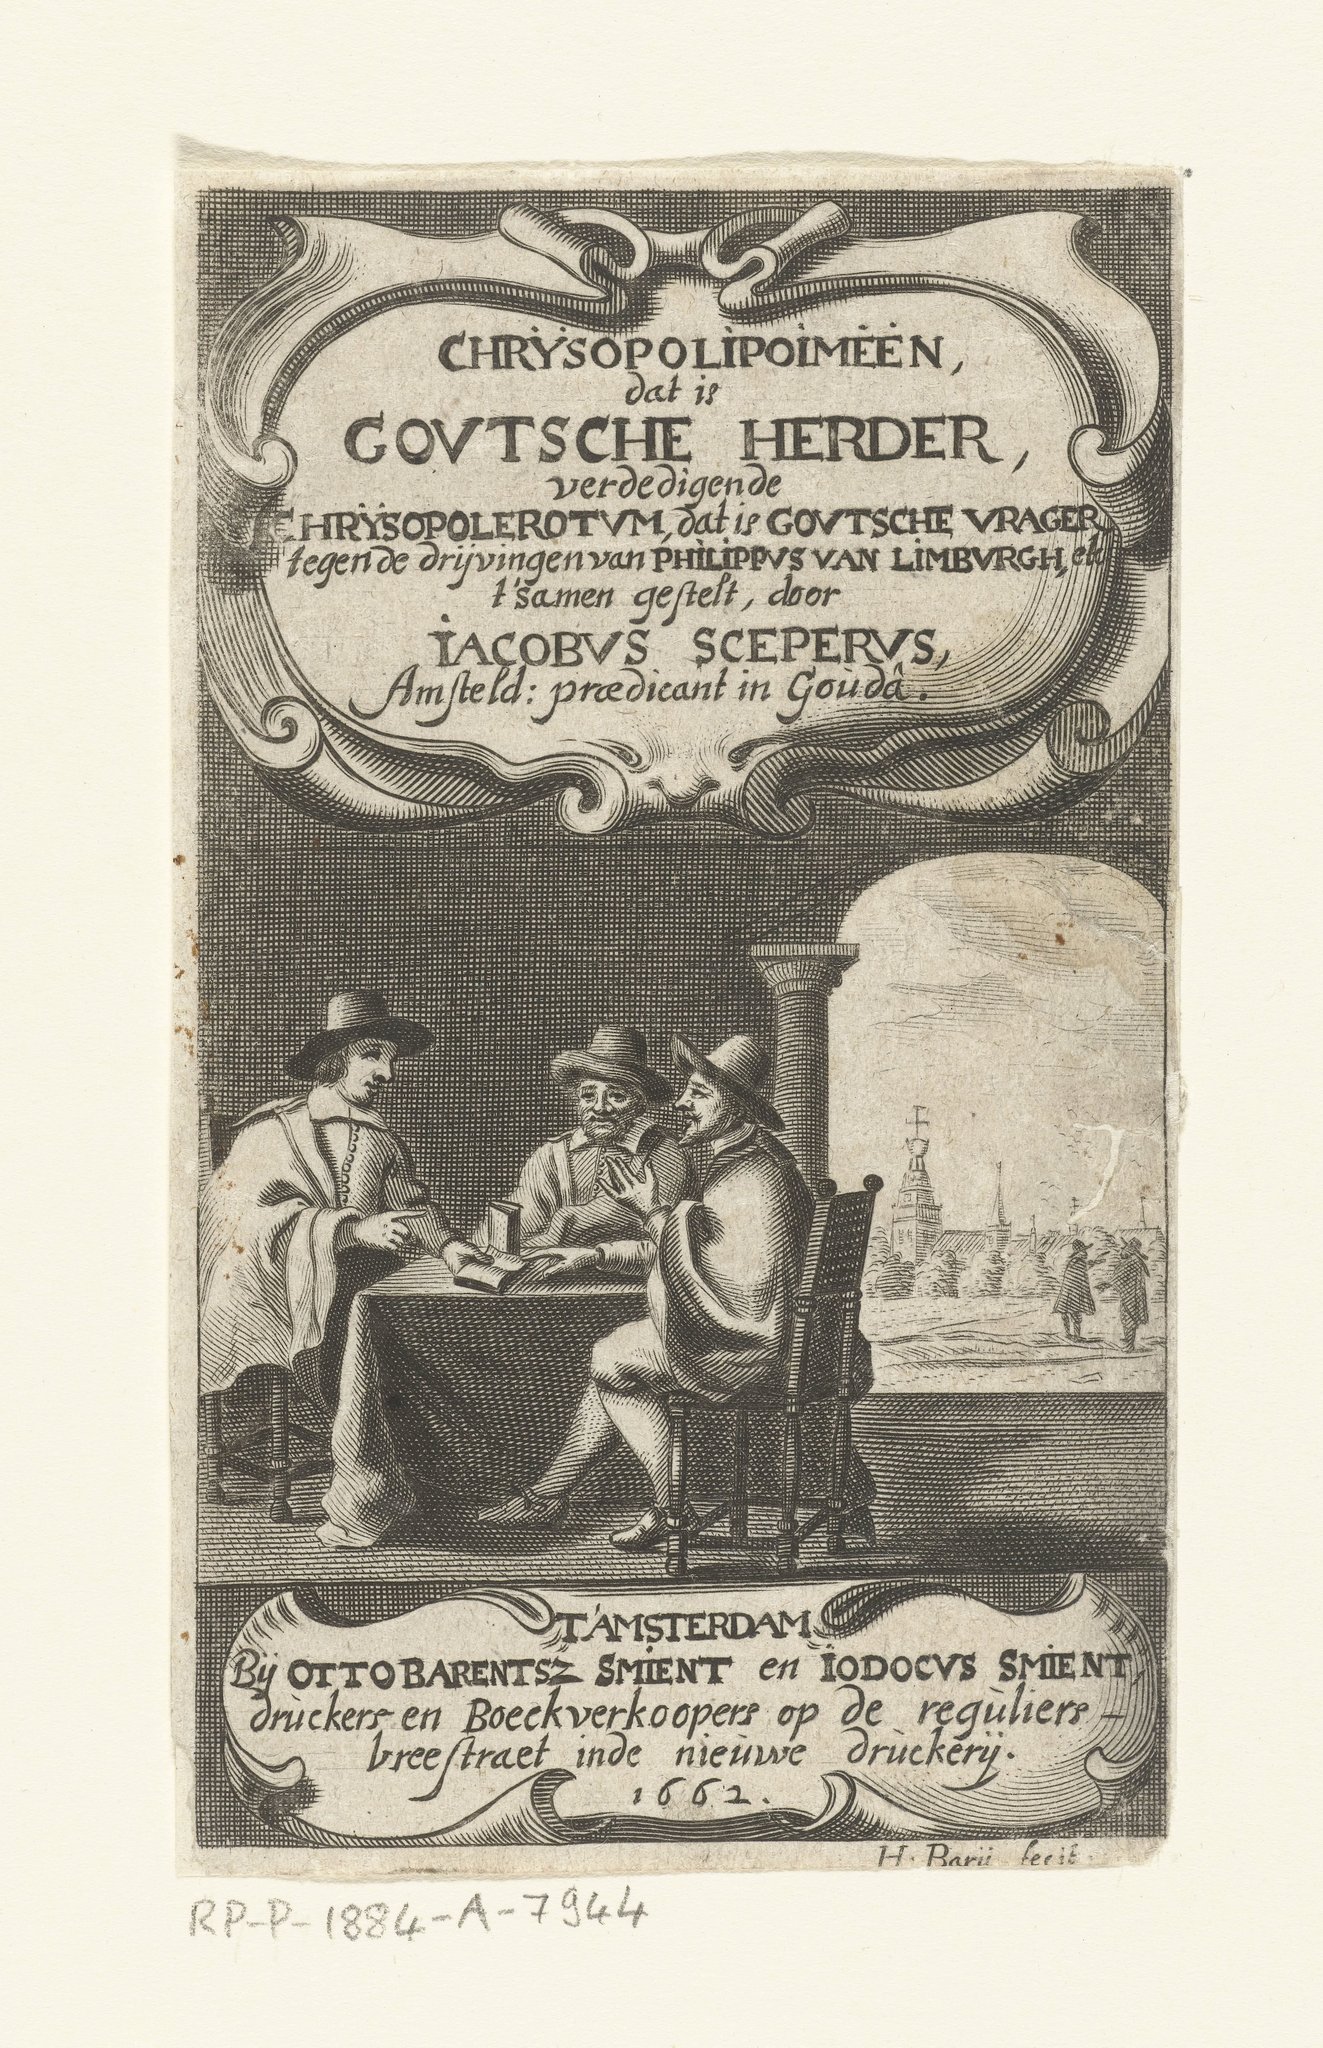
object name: titelblad, titelpagina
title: Titelpagina voor: J. Sceperus, Chrysopolipoimeen, dat is Govtsche herder, verdedigende Chrysopolerotvm, dat is Govtsche vrager, tegen de drijvingen van Philippvs van Limbvrgh, Amsterdam, 1662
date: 1662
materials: paper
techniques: engraving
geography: netherlands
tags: debate, discussion (~ meeting)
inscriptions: collector's mark: Lugt 2228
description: Titelpagina voor: J. Sceperus, Chrysopolipoimeen, dat is Govtsche herder, verdedigende Chrysopolerotvm, dat is Govtsche vrager, tegen de drijvingen van Philippvs van Limbvrgh, Amsterdam, O.B. Smient en J. Smient, 1662